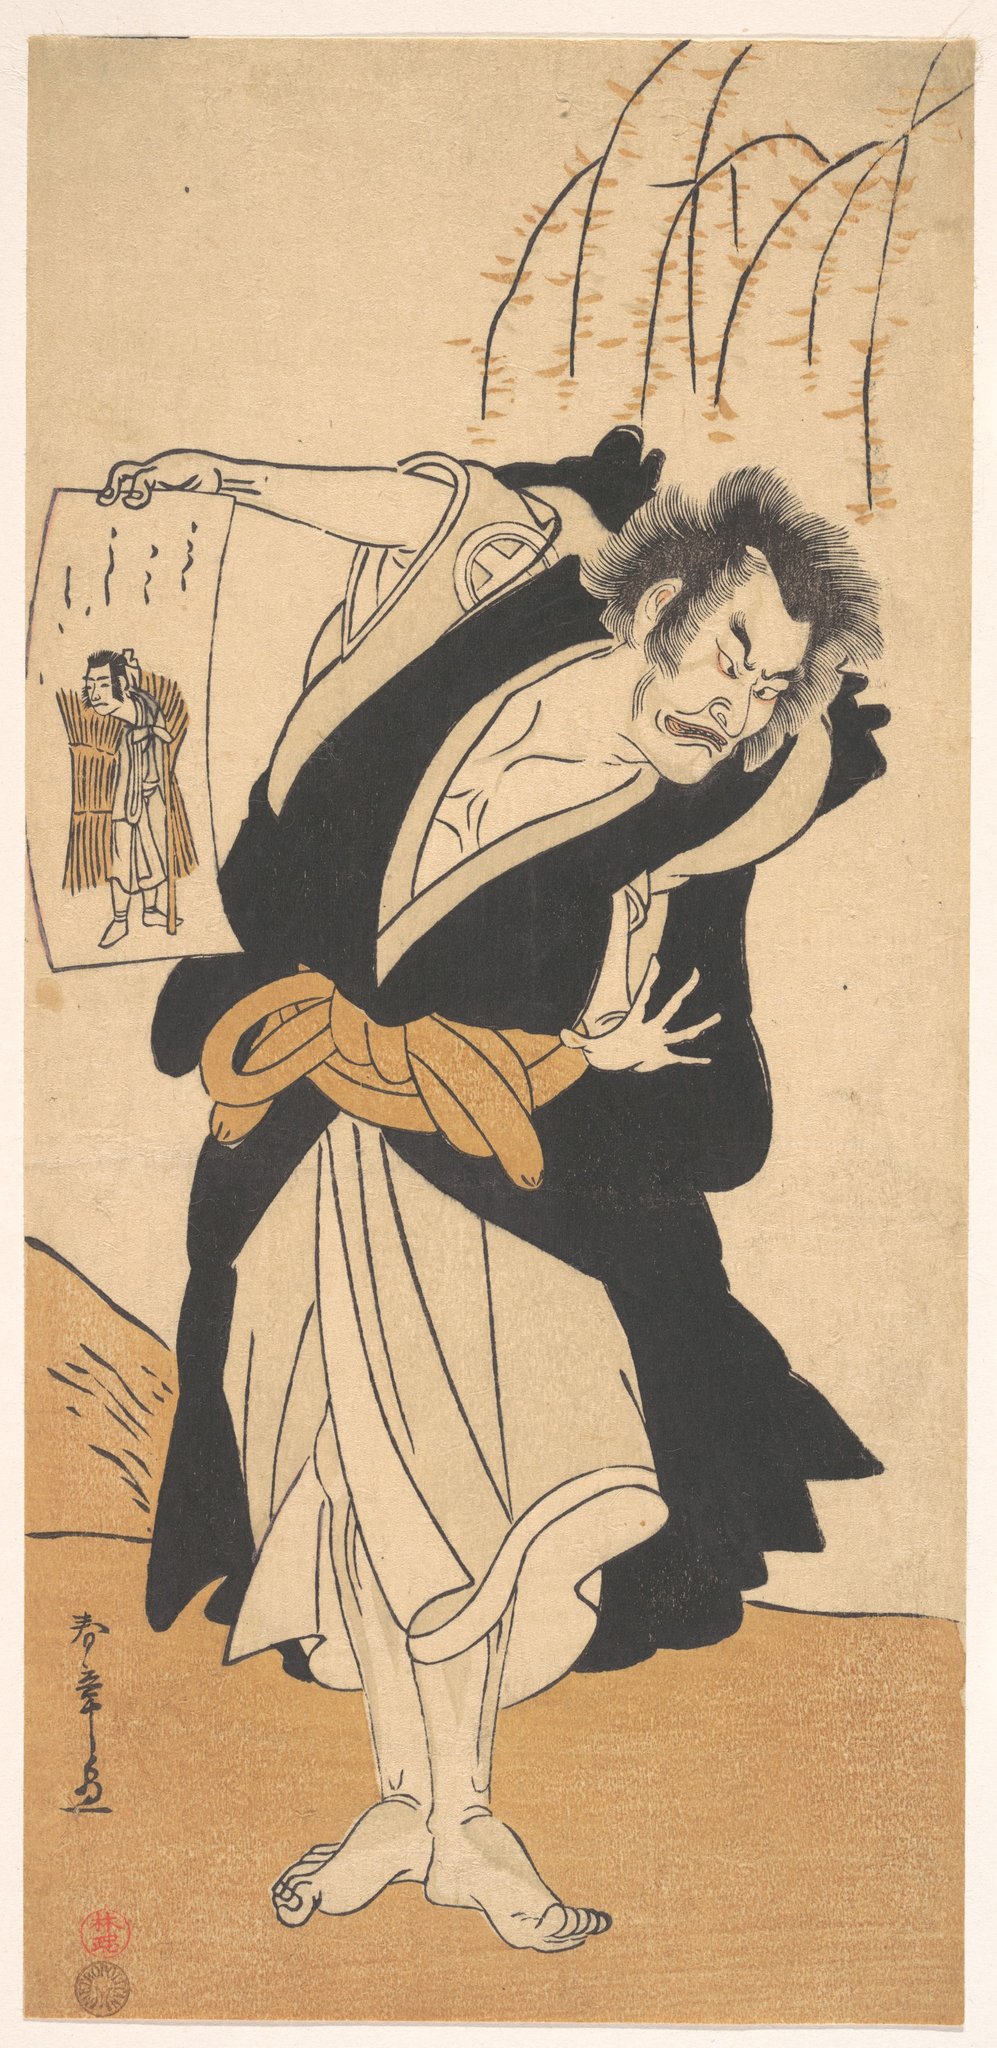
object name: woodblock print nishiki e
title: The Third Otani Hiroemon as an Outlaw Standing Near a Willow Tree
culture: japanese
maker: katsukawa shunshō 勝川春章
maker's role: artist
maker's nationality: japanese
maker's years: 1726-1792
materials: ink, paper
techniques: nishiki e, woodblock print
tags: men,actors